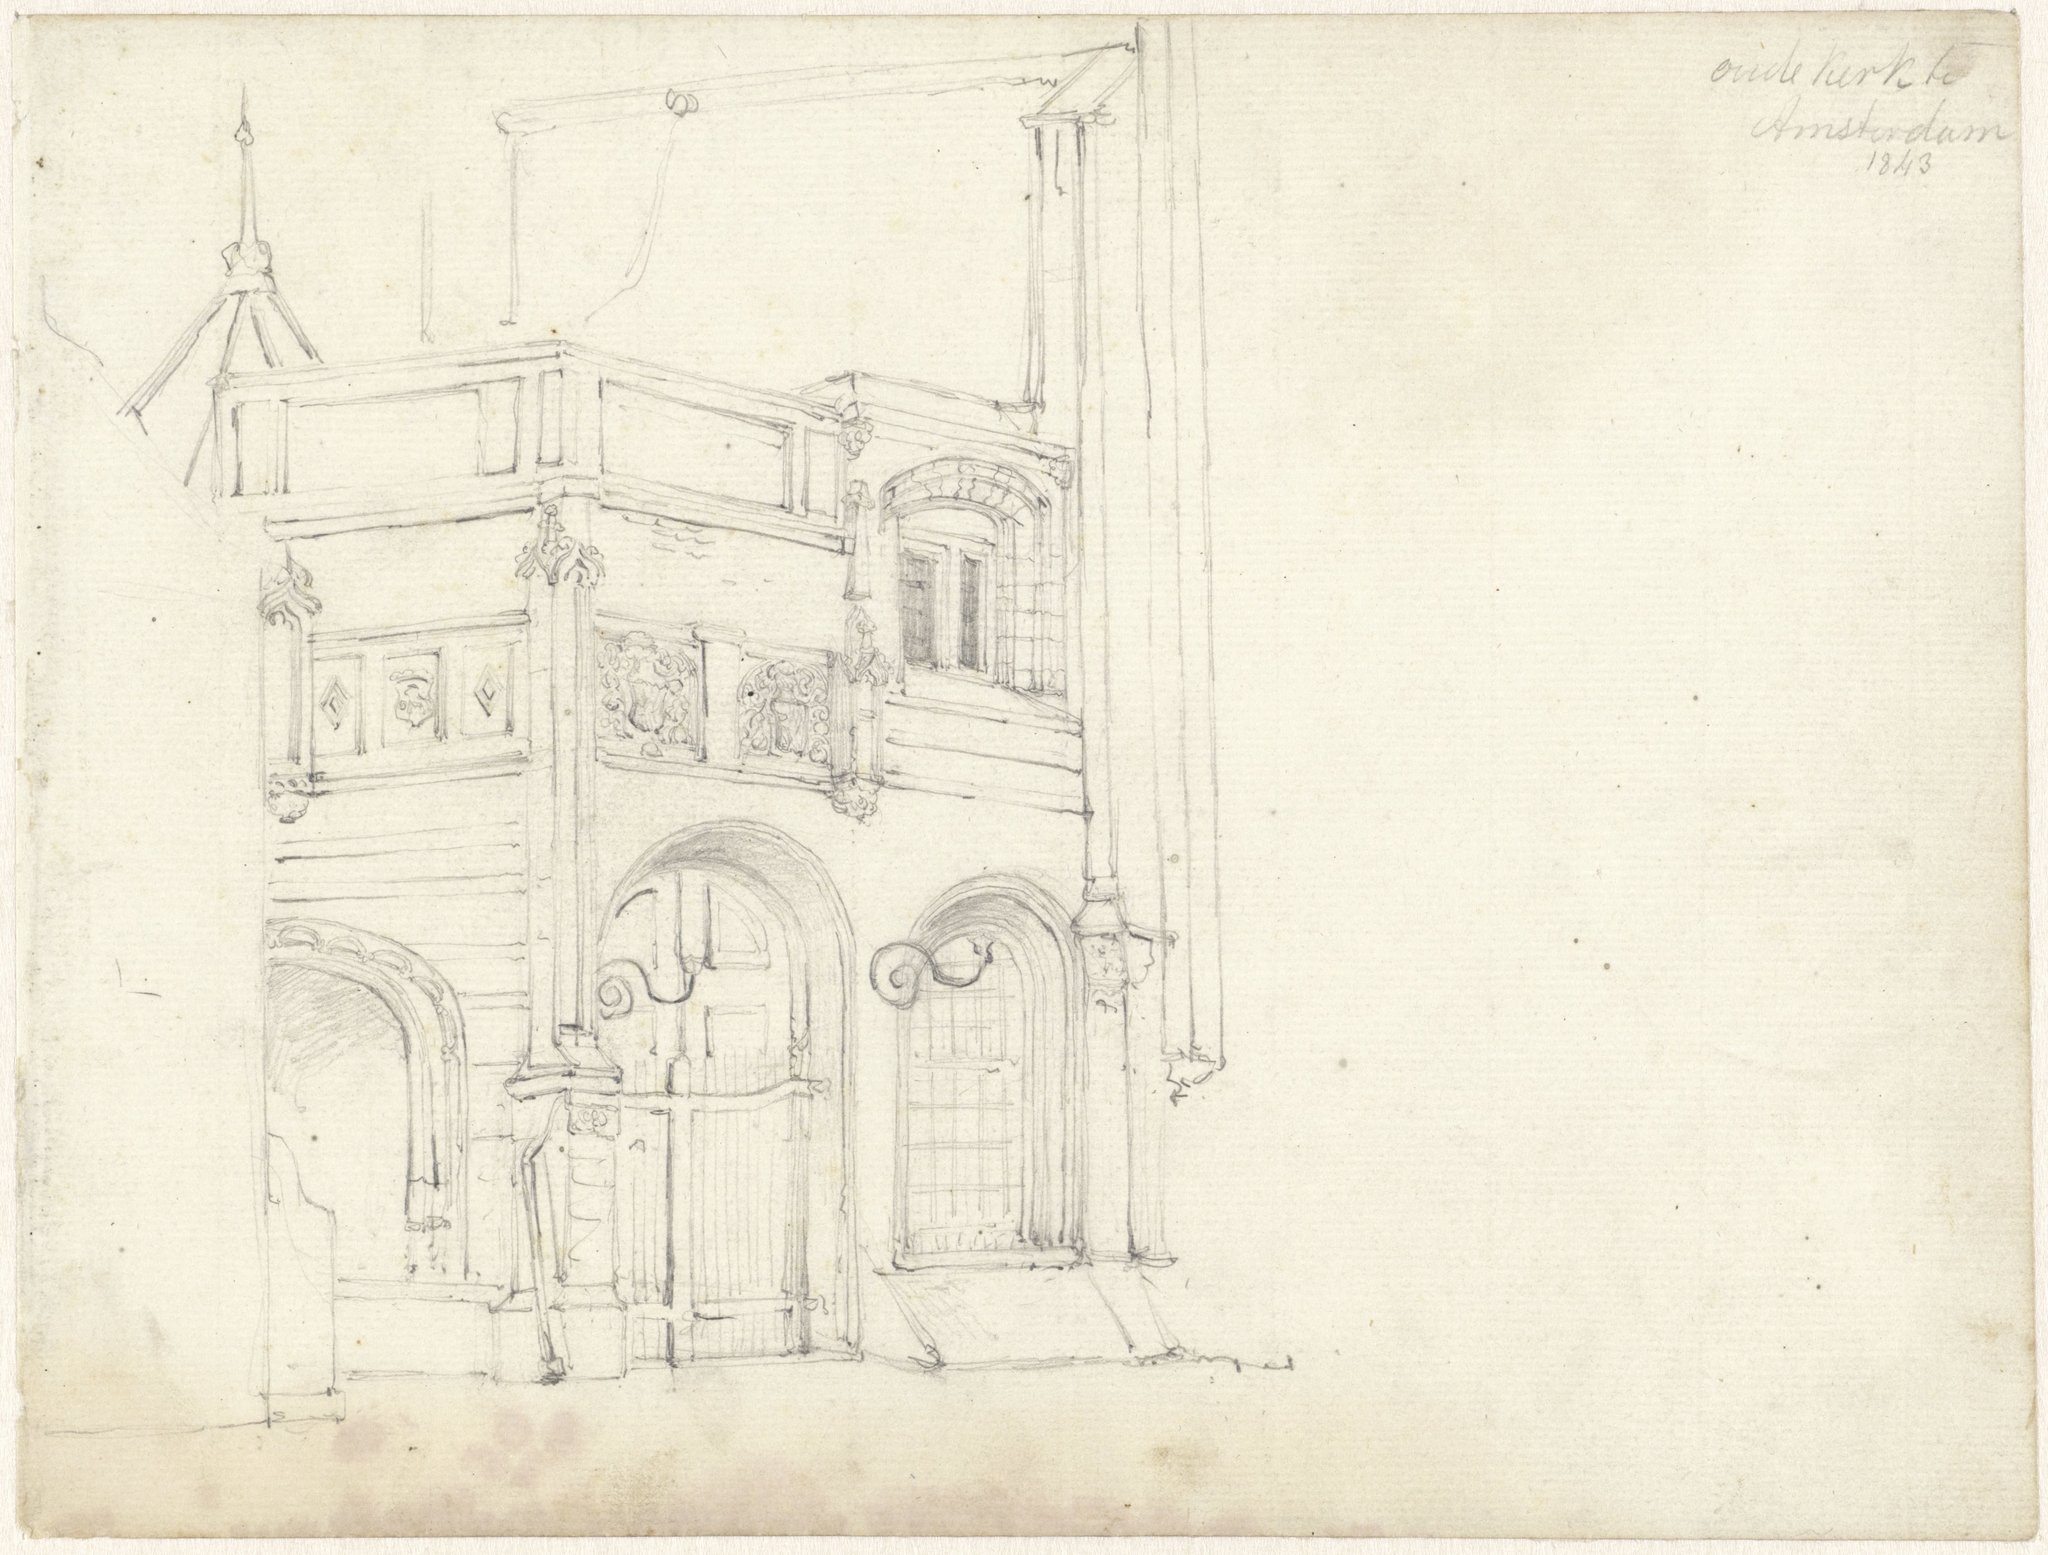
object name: drawing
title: IJzeren kapel en het Zuider portaal aan de Oude Kerk te Amsterdam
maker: johan adolph rust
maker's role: draughtsman, painter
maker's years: 1828-1915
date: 1843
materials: paper, pencil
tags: church (exterior)